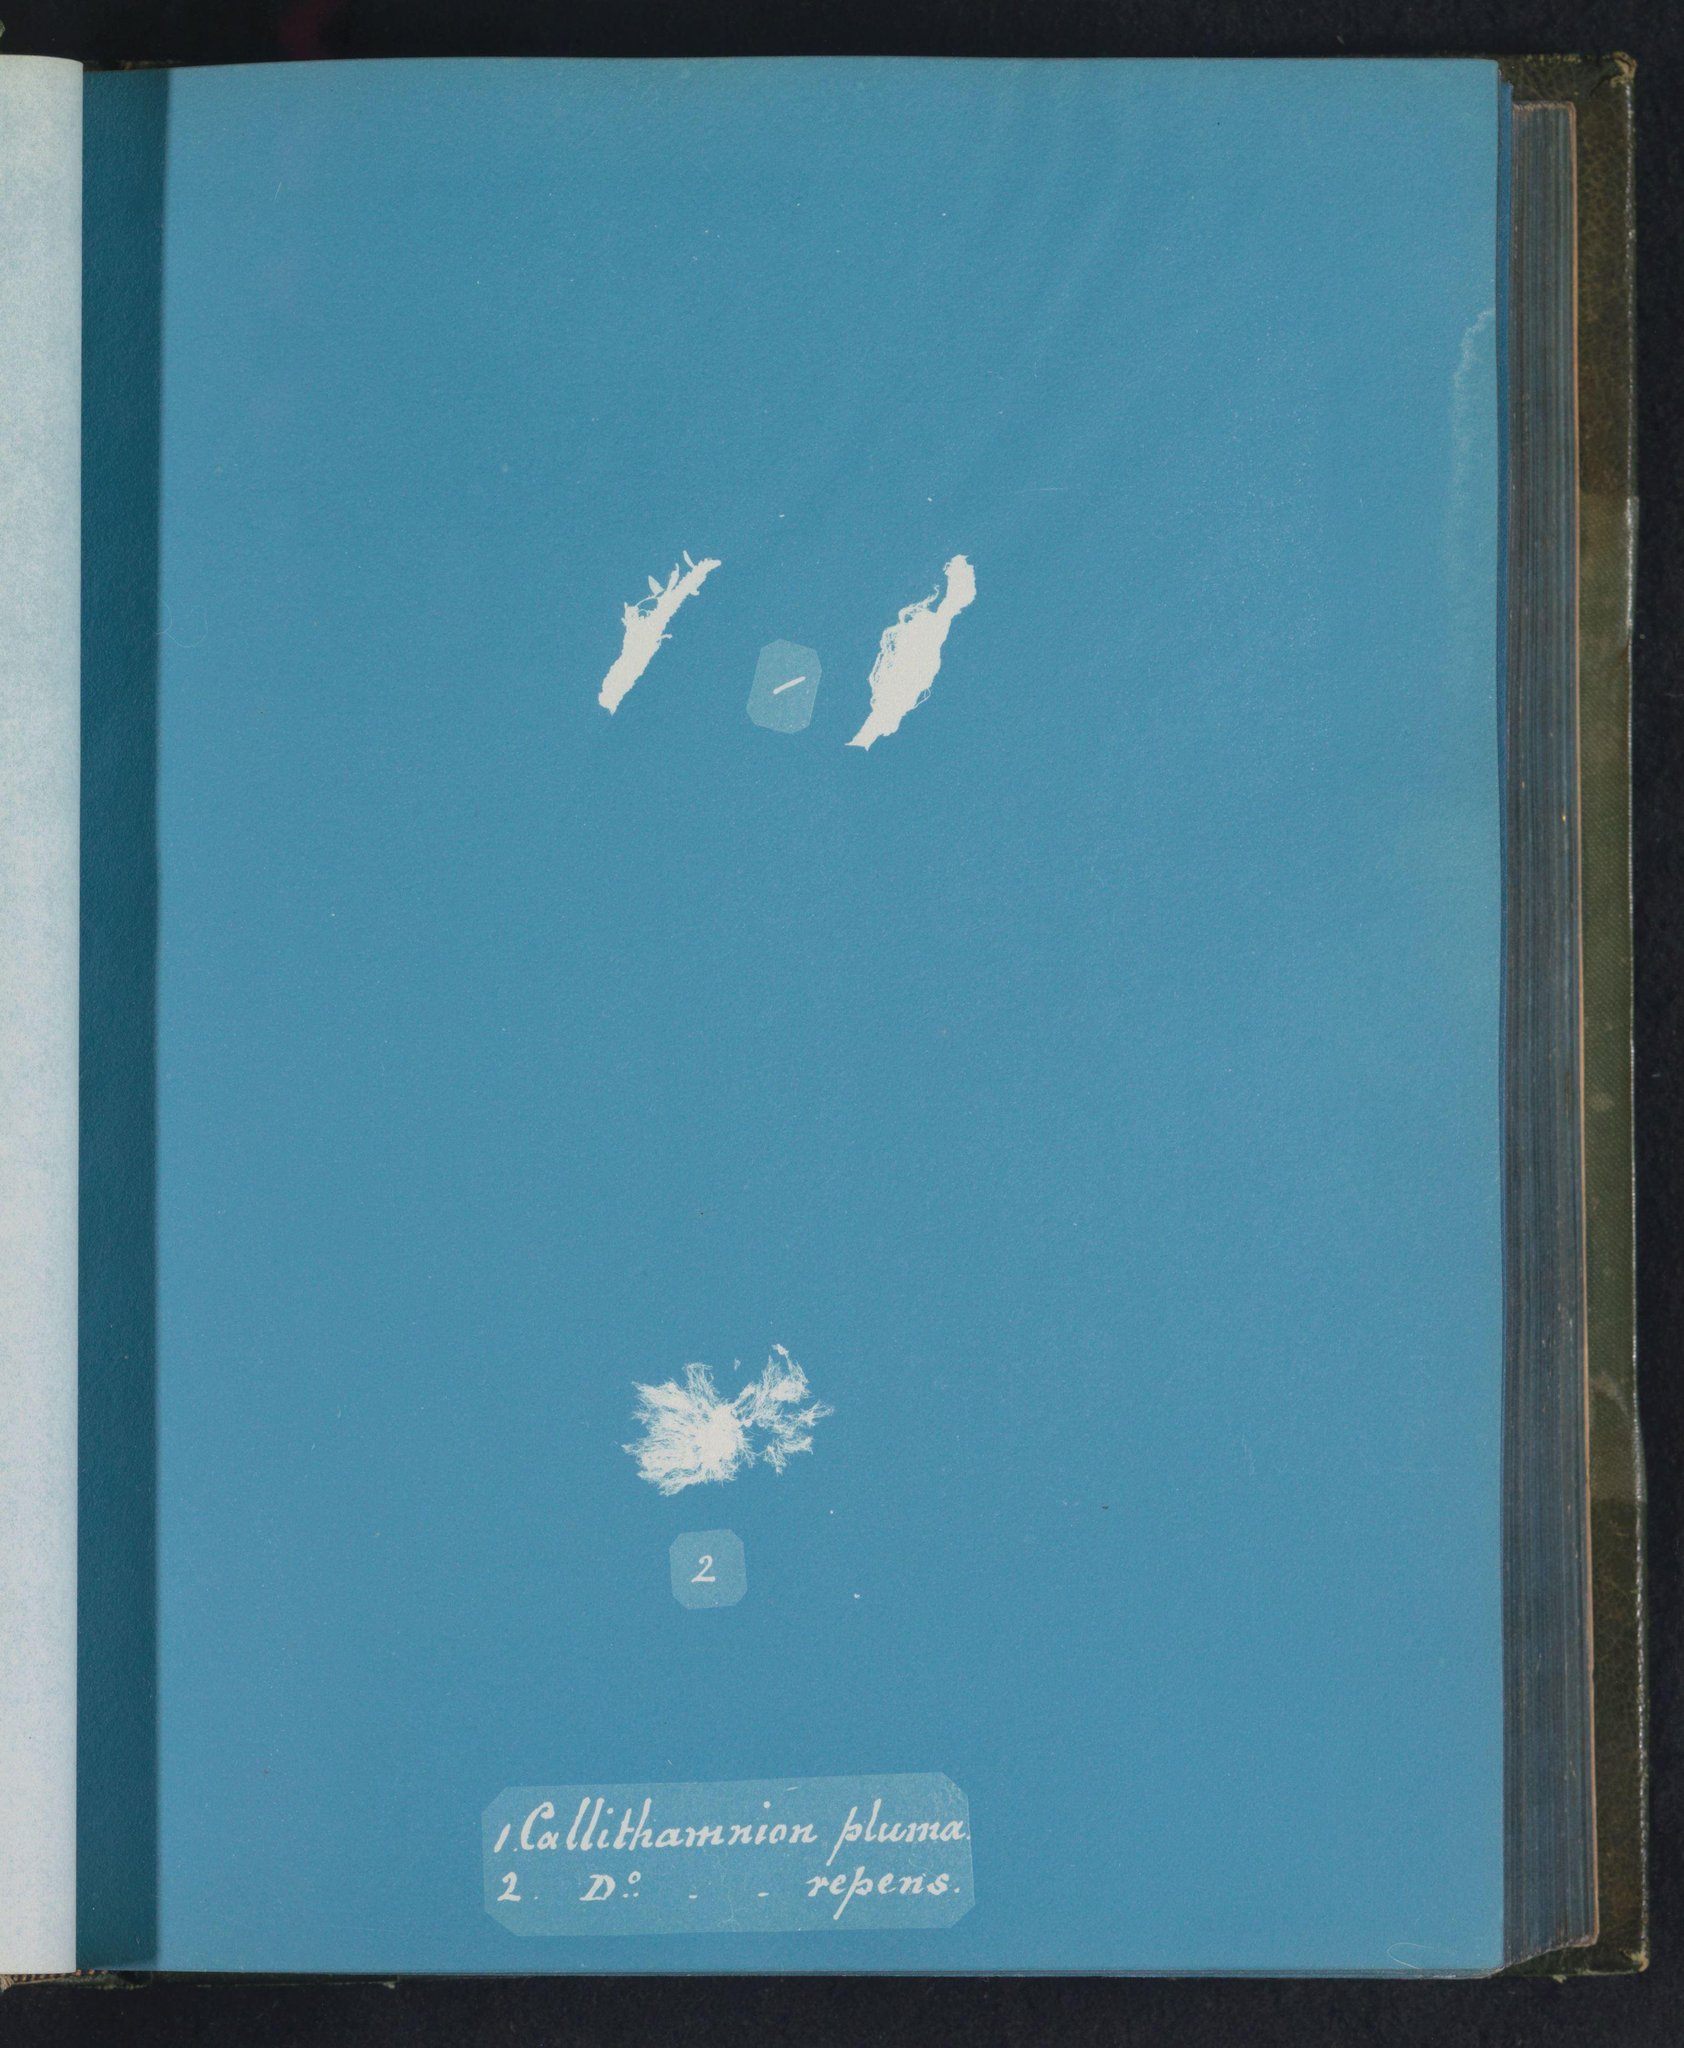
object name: photograph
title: Zeewier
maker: anna atkins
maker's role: fotograaf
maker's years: 1799-1871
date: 1843-1853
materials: photographic support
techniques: cyanotype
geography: united kingdom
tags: algae, seaweed